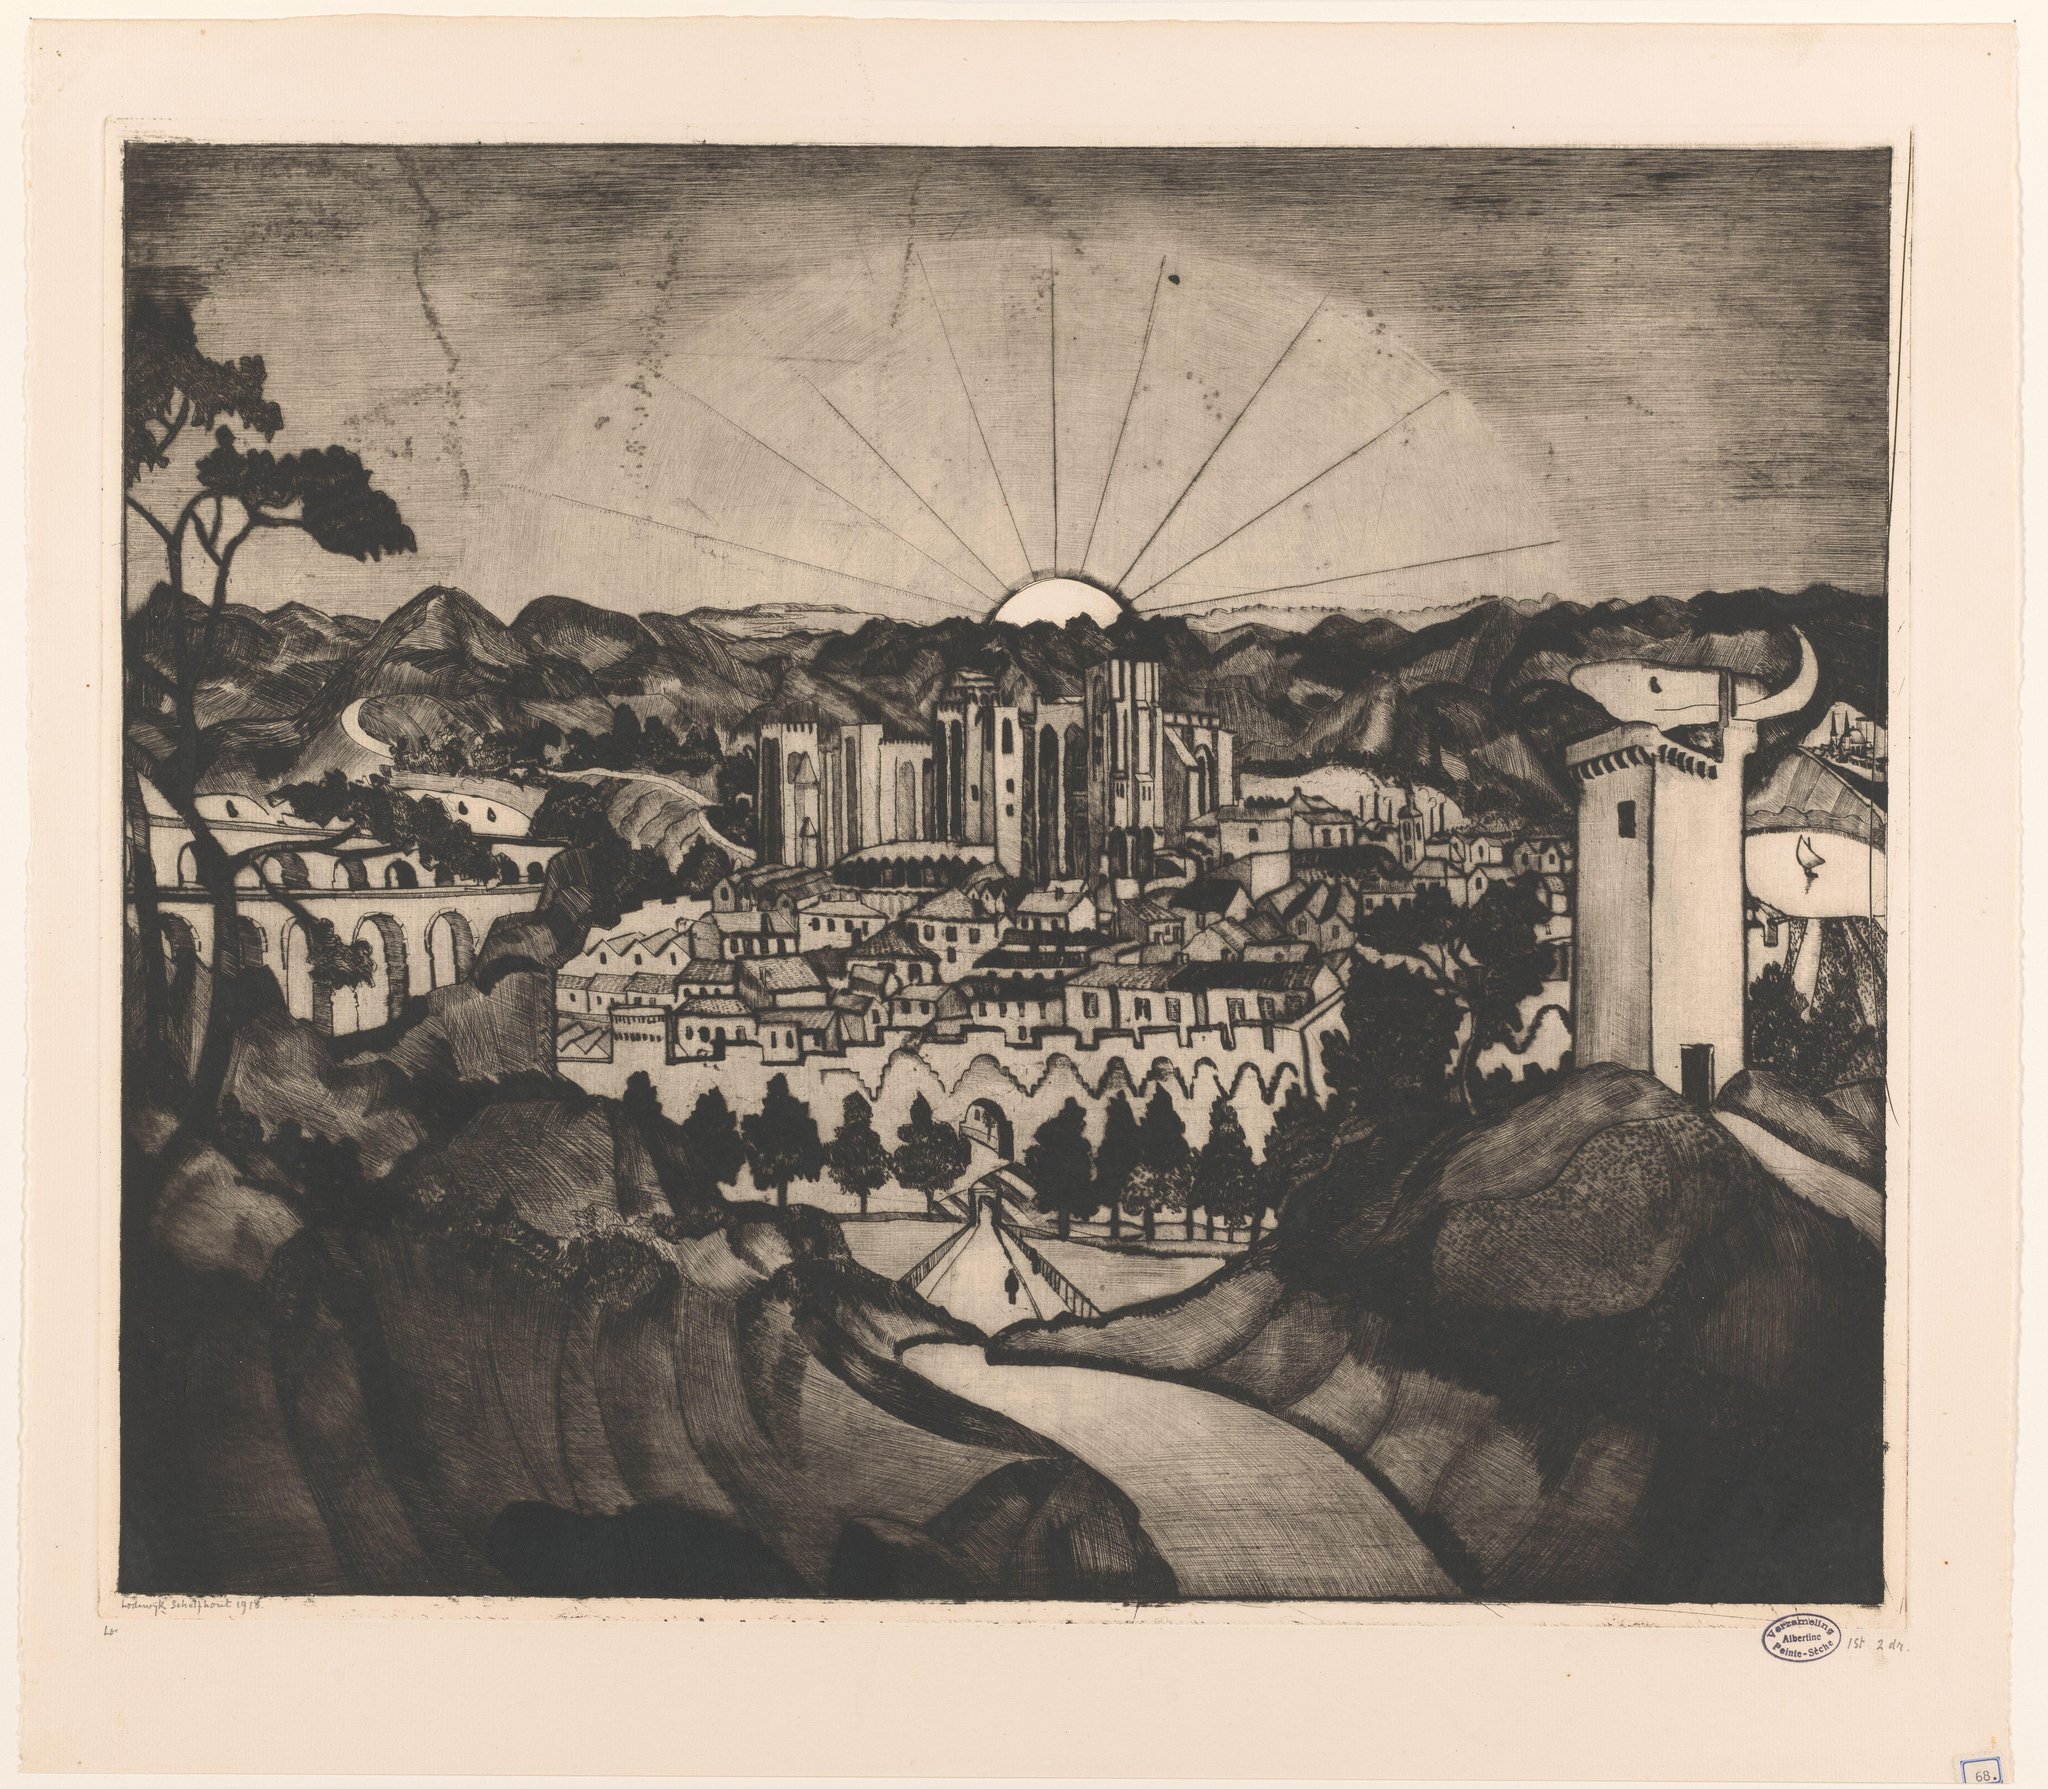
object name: print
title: Avignon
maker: lodewijk schelfhout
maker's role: draughtsman, print maker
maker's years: 1881-1943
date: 1918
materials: paper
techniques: drypoint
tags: city-view, and landscape with man-made constructions, sun as celestial body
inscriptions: collector's mark: Lugt 5i, collector's mark: Lugt 2228, collector's mark: Lugt 2760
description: De opgaande of ondergaande zon boven de stad Avignon in het zuiden van Frankrijk.